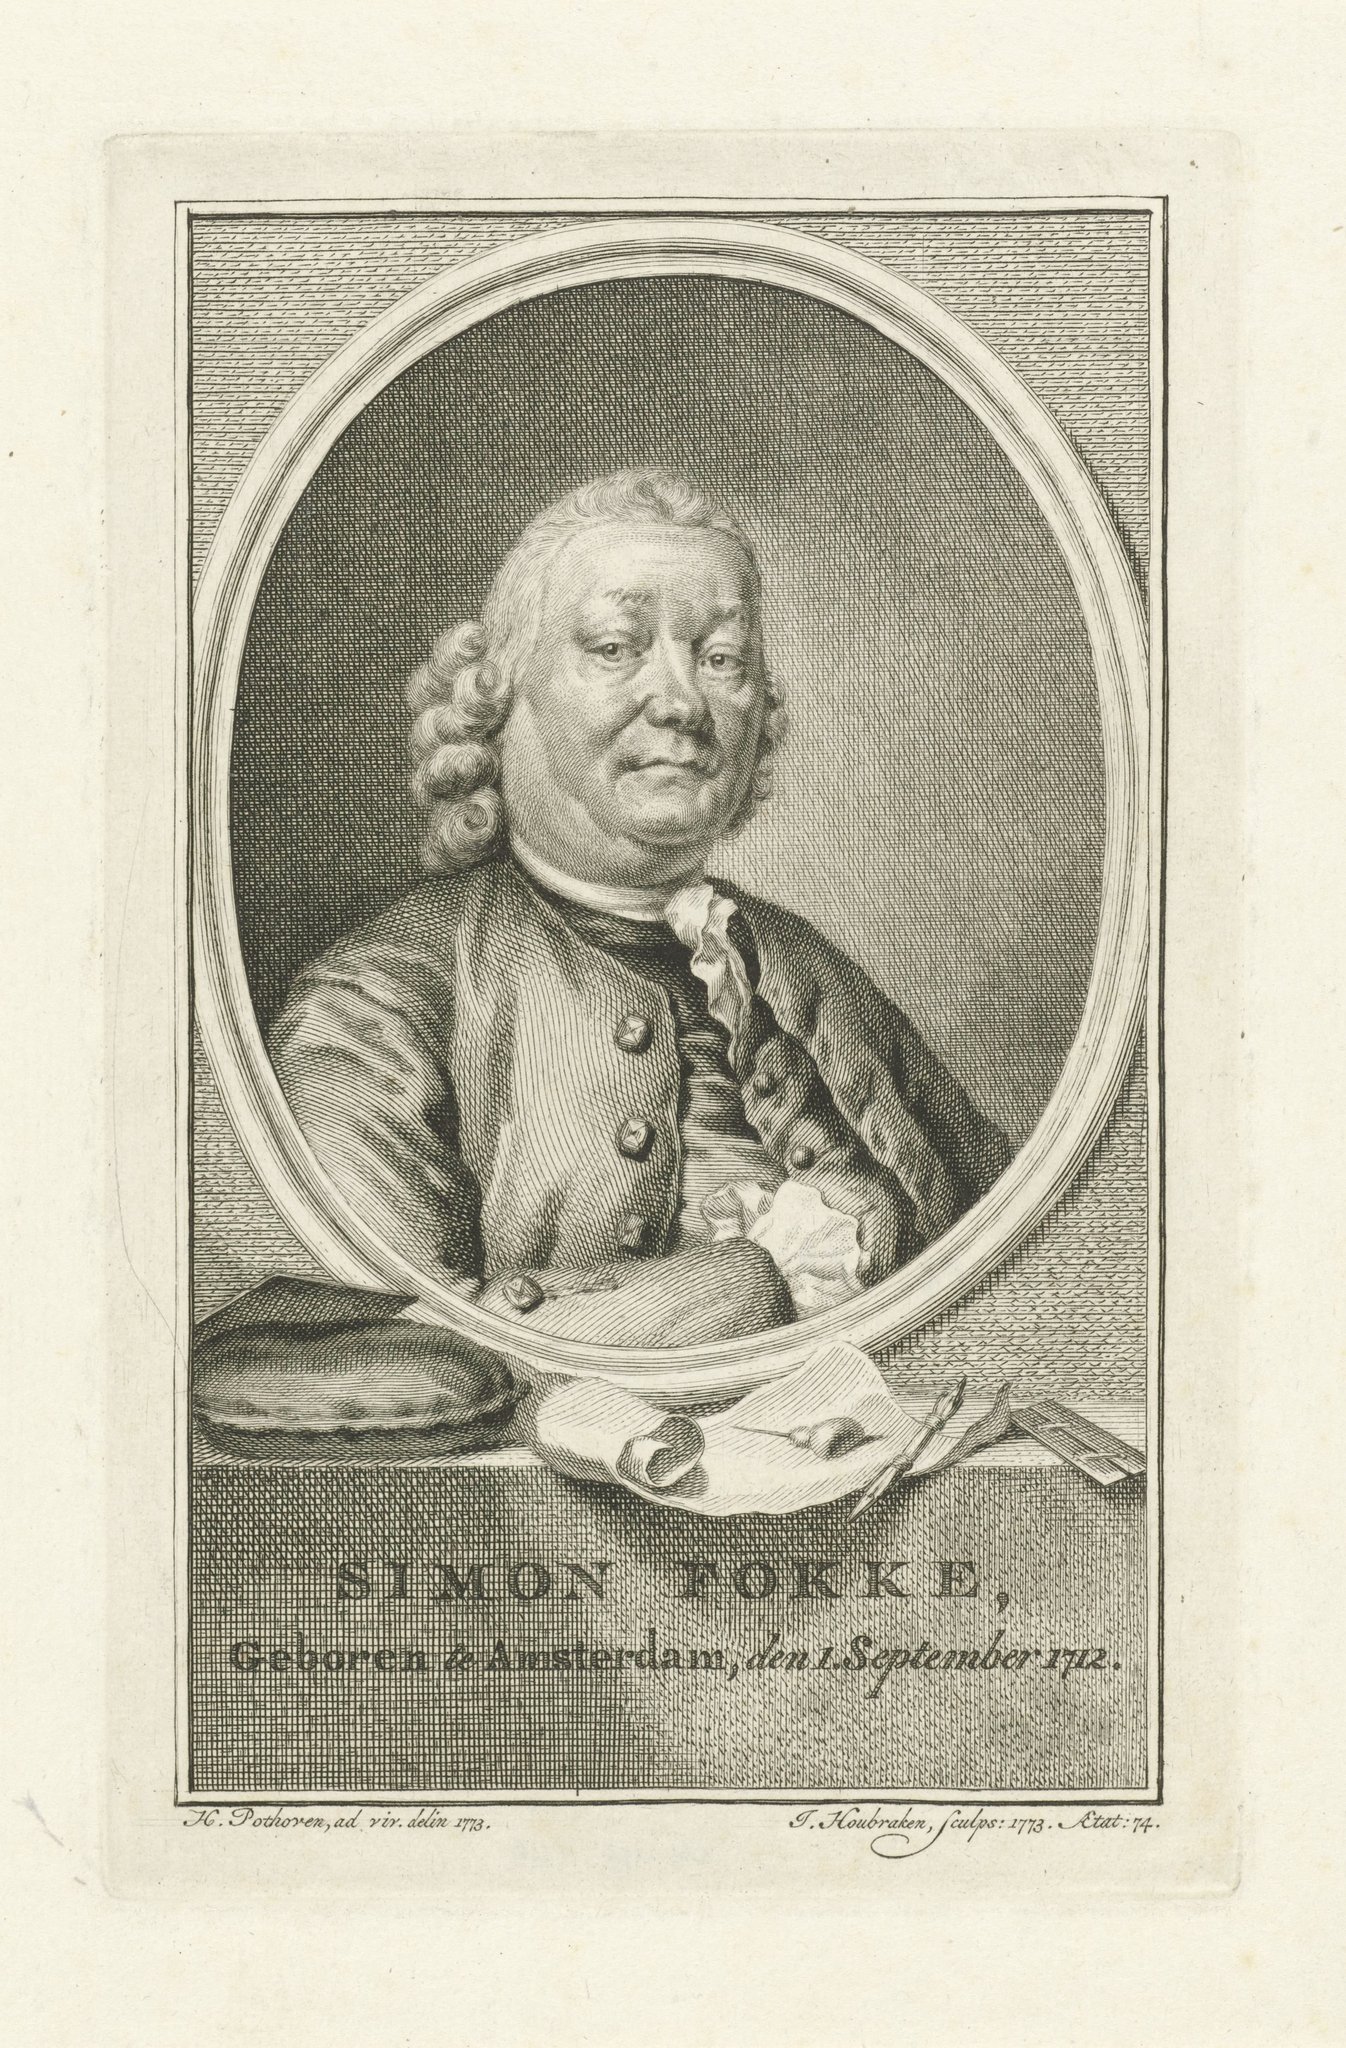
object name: print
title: Portret van Simon Fokke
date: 1773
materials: paper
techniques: engraving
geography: amsterdam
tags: draughtsman, simon fokke, tools, implements of graphic artist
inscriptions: collector's mark: Lugt 2228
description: Portret van de graveur Simon Fokke in een ovaal. Het portret rust op een plint waarop het gereedschap van de graveur: burijn, etsnaald en papier. Onder het portret zijn naam en gegevens in twee regels in het Nederlands.